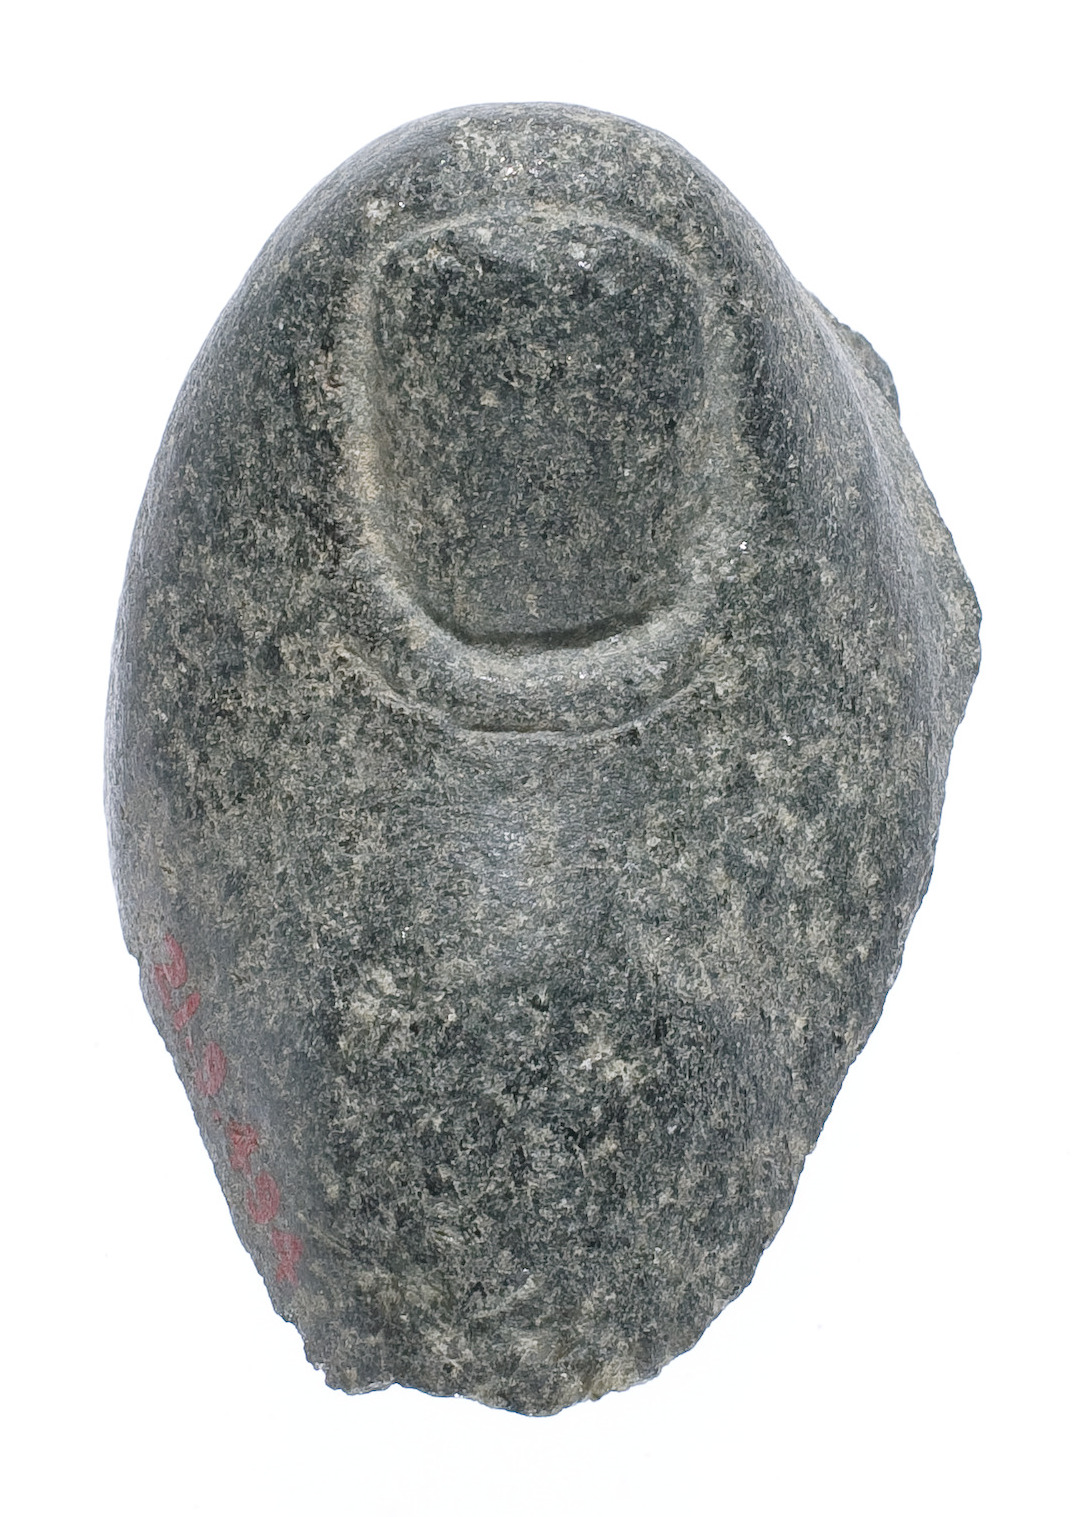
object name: right toe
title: Right big toe of a statue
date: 1353-1336 BCE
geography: egypt